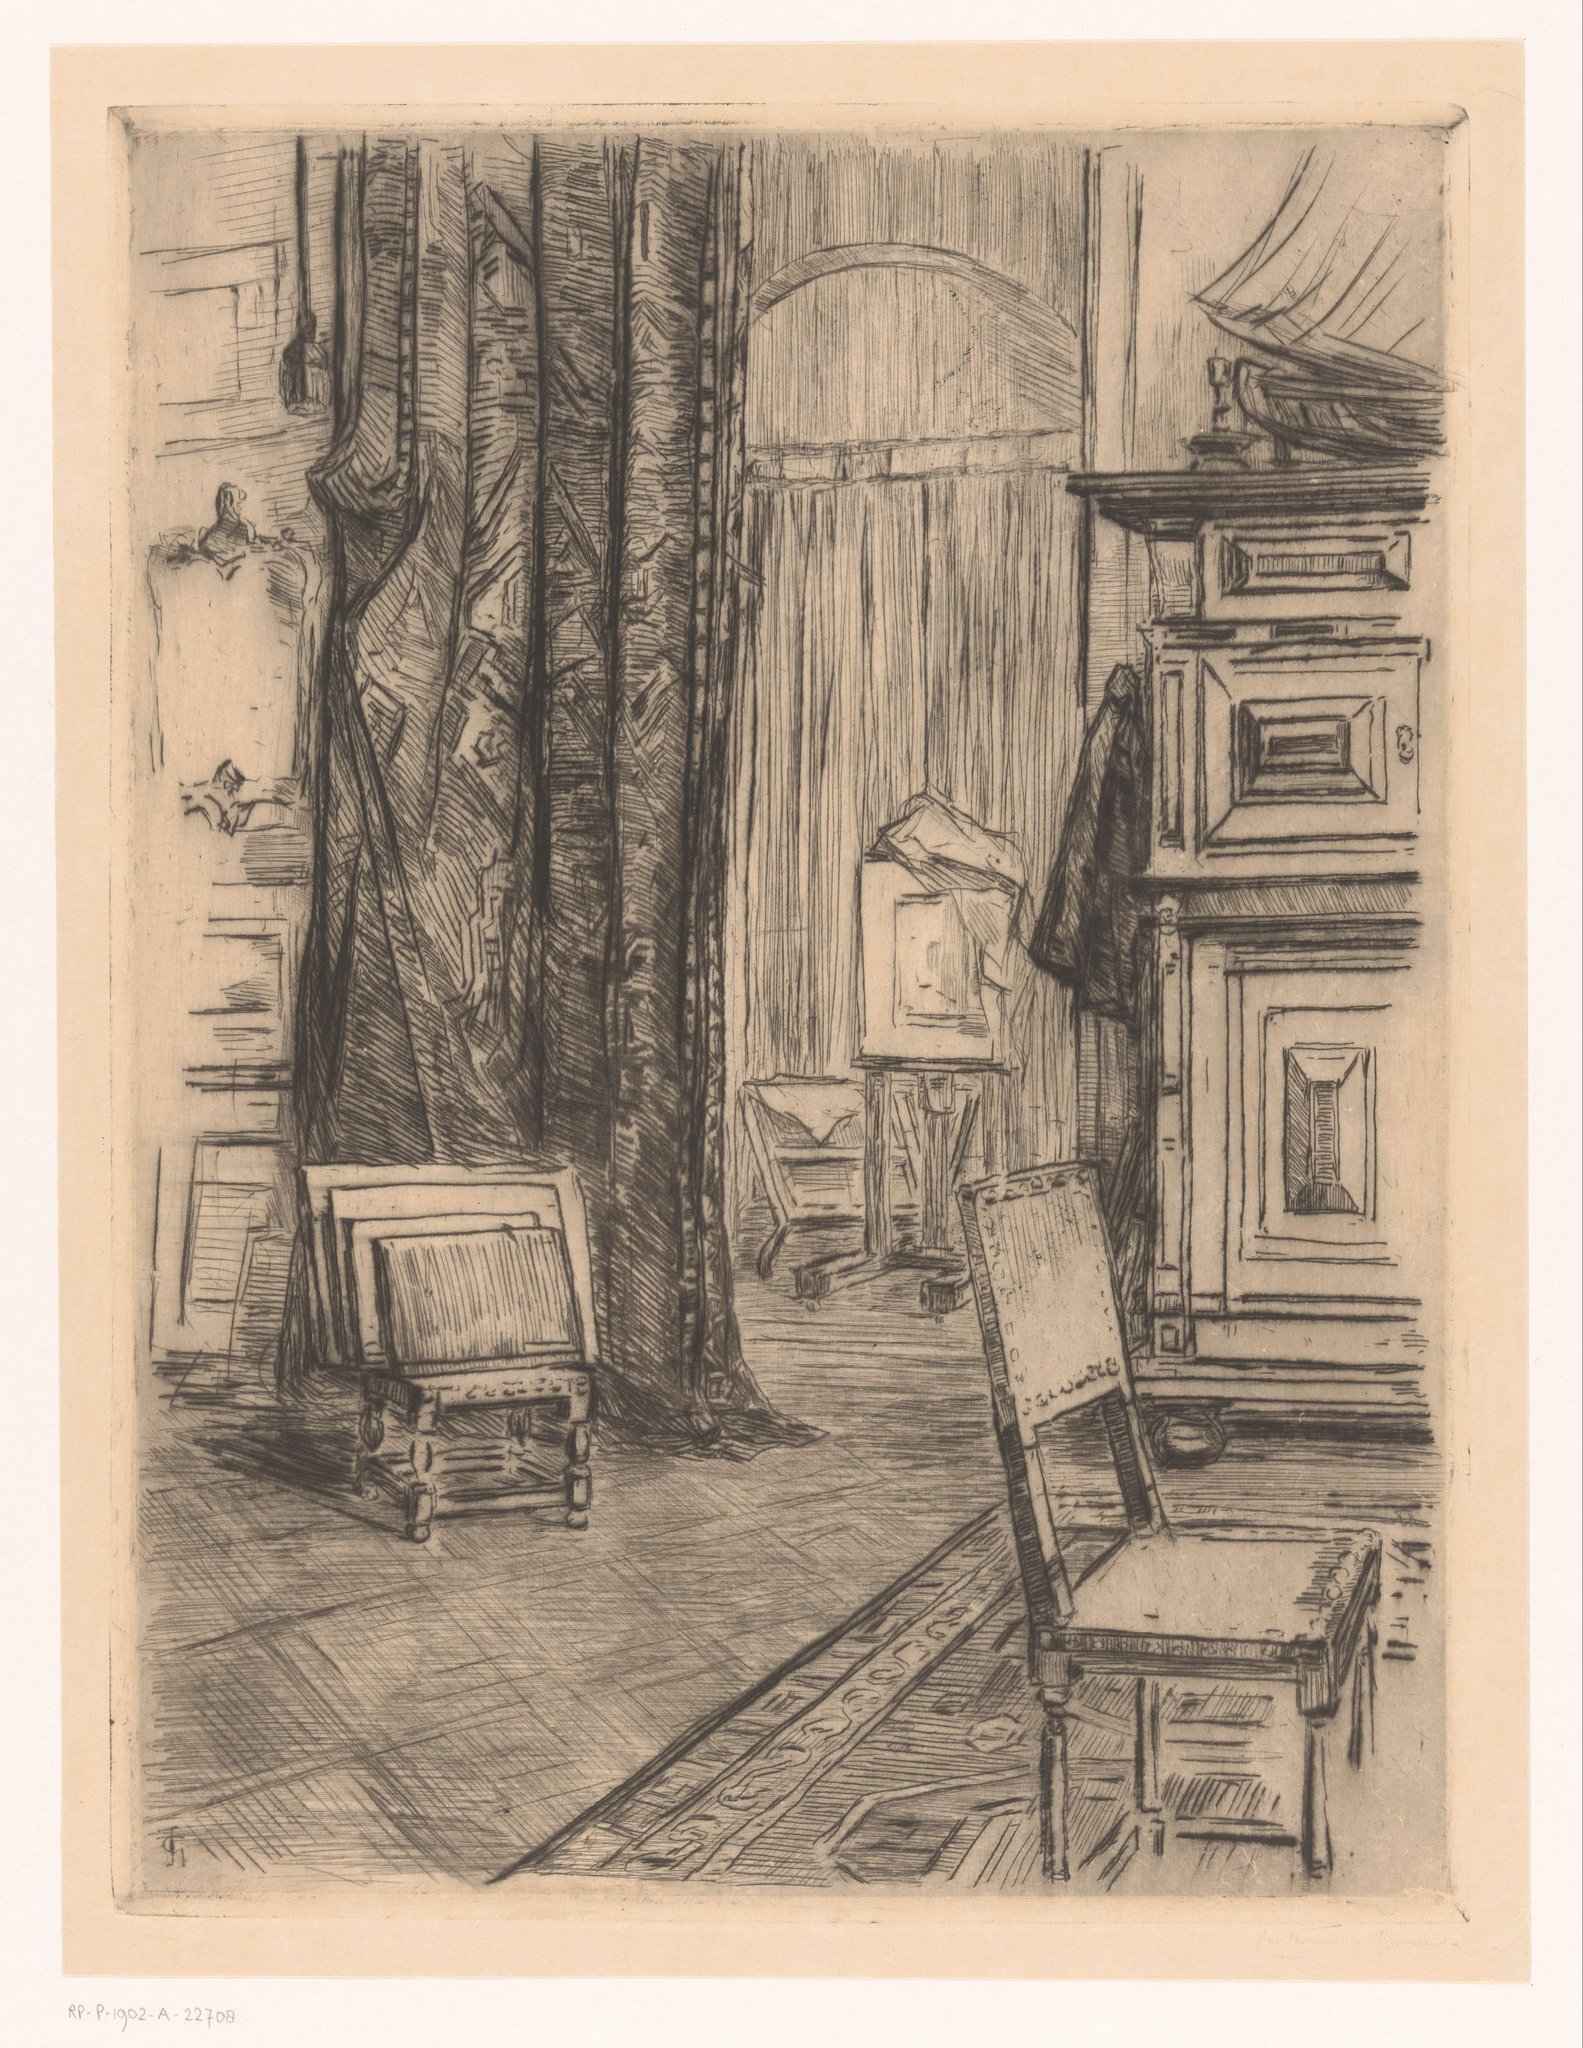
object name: print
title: Interieur van een atelier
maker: carel nicolaas storm van s-gravesande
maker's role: draughtsman, print maker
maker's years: 1841-1924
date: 1851-1902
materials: paper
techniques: drypoint, intaglio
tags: workshop, studio ~ painter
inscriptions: collector's mark: Lugt 2228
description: Twee vertrekken die worden gescheiden door een gordijn. In het voorste vertrek staat een schraag met mappen en papieren; in het achterste vertrek staat een schildersezel. Mogelijk het atelier van de kunstenaar in Wiesbaden.